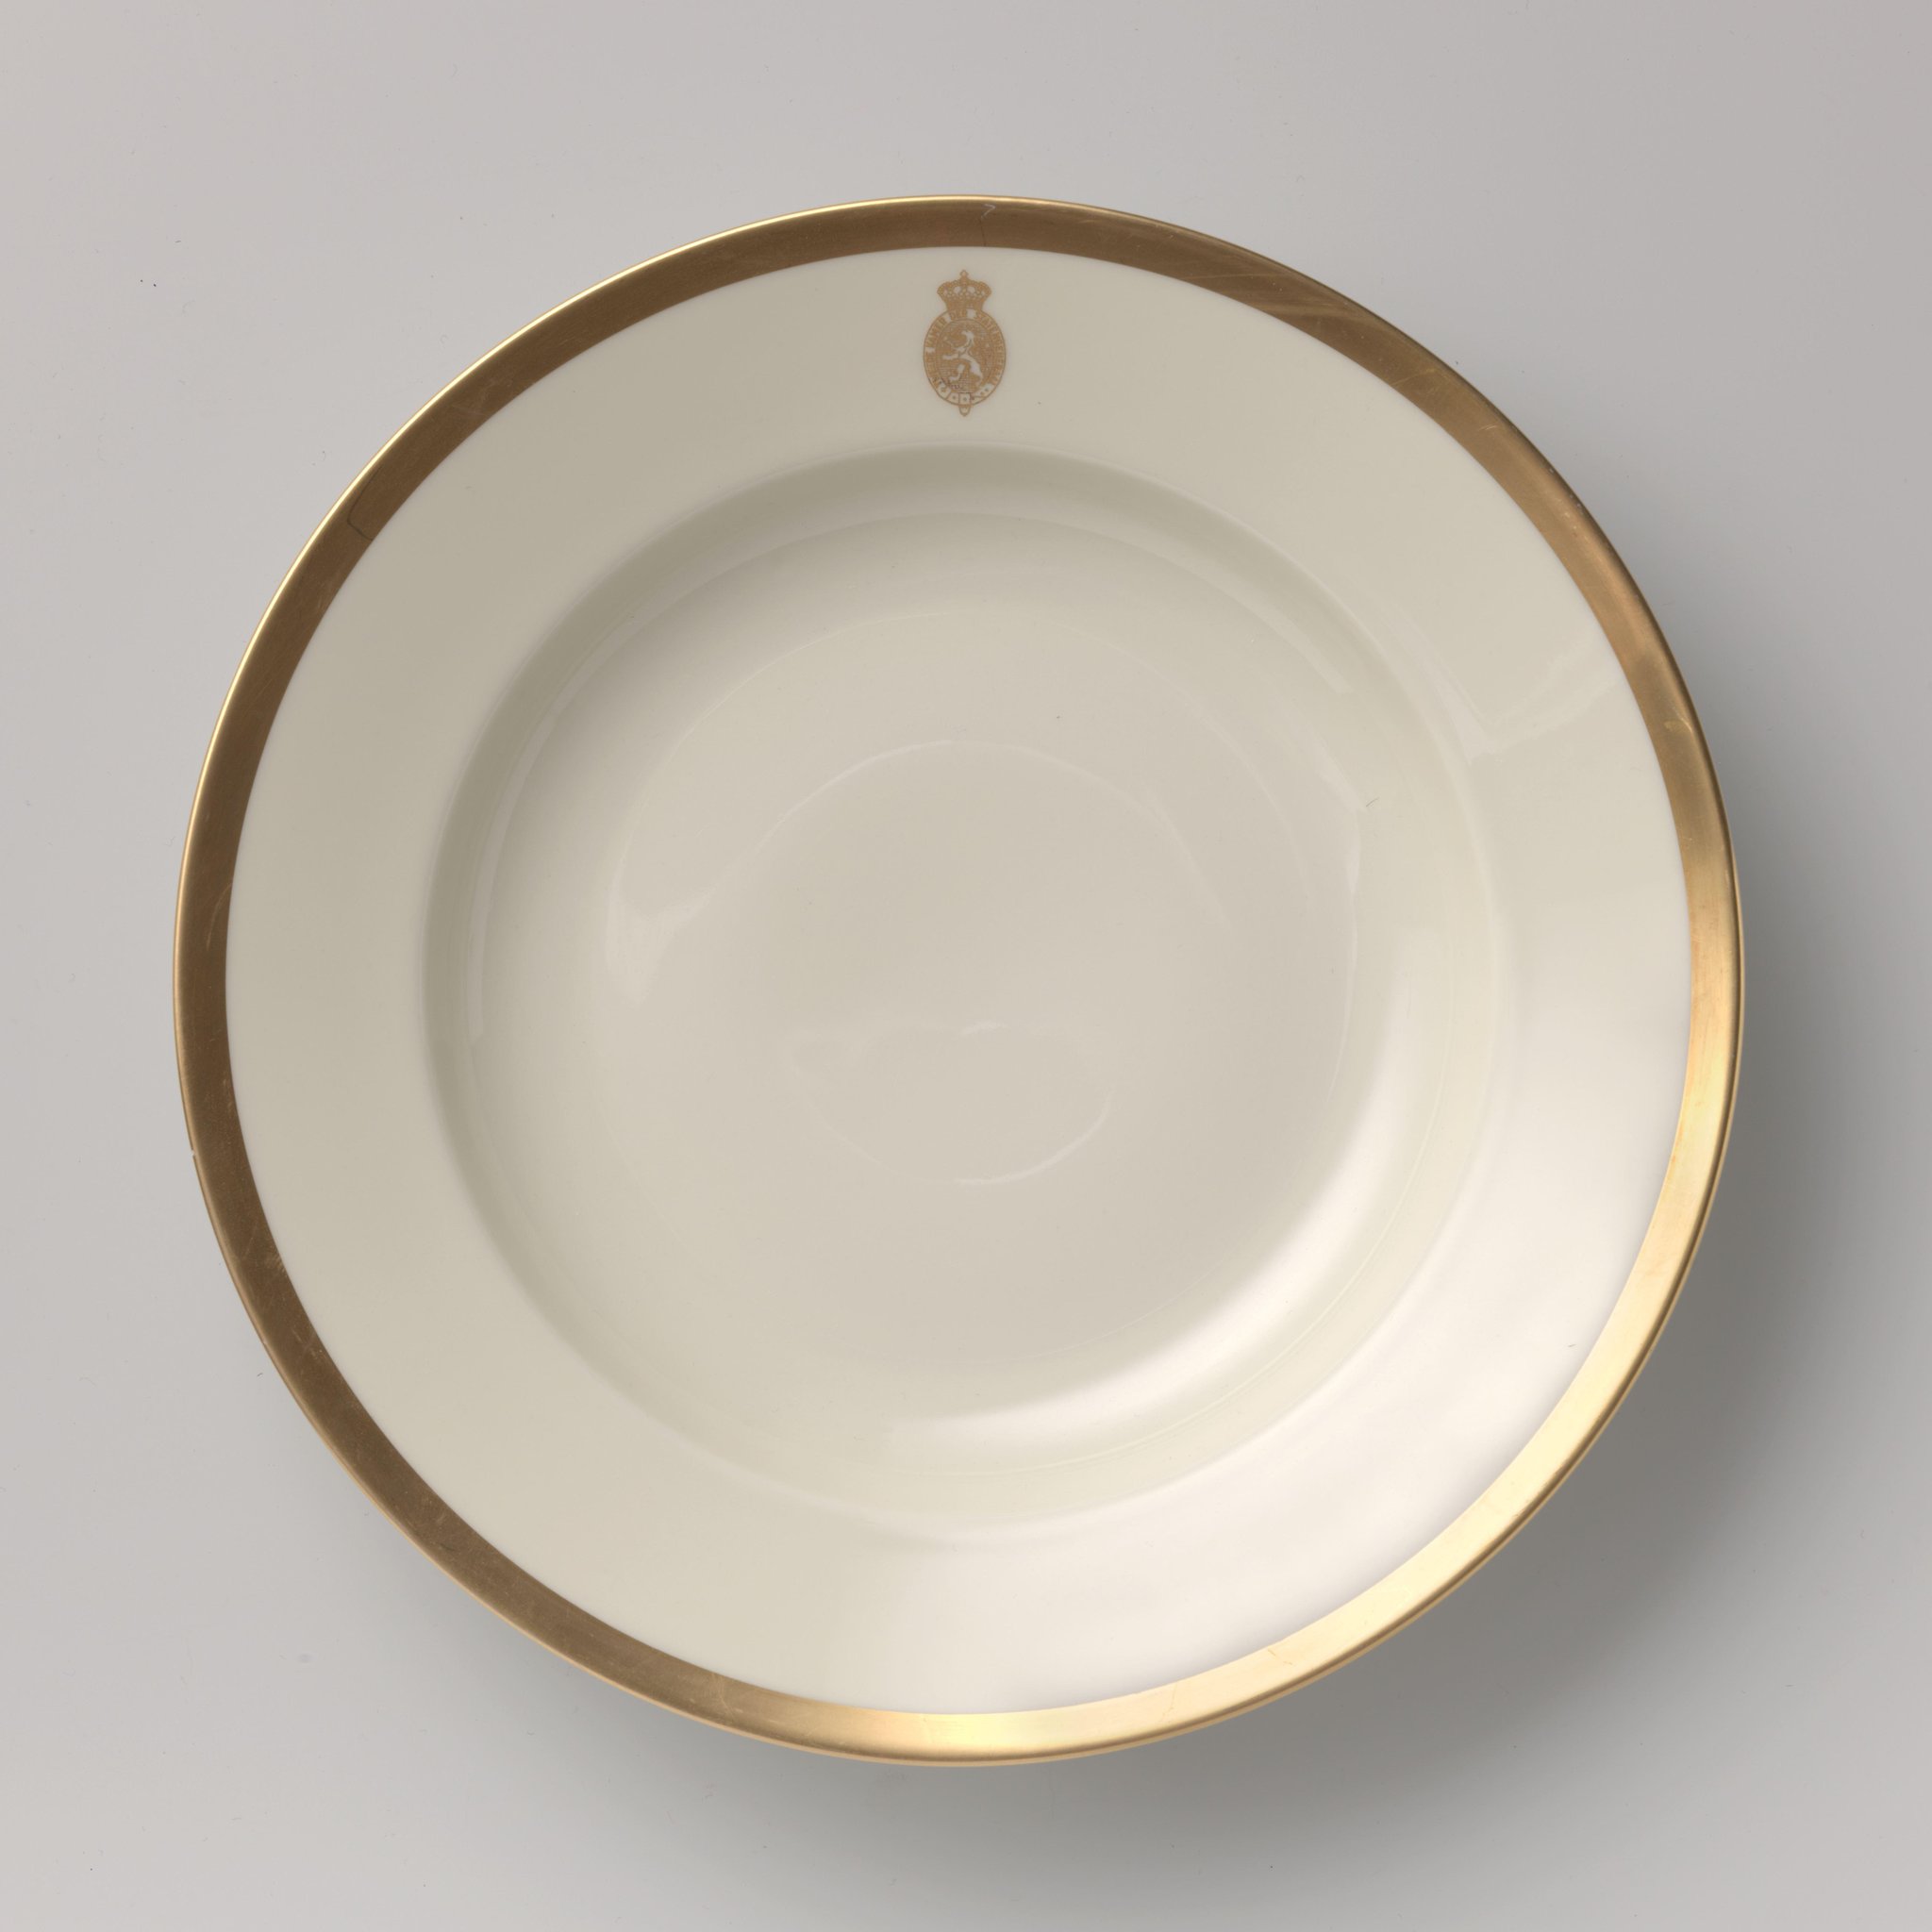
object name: plate dish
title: Plate used in the House of Representatives of the Netherlands at official receptions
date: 1900-1974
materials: glaze, gold, paint, porcelain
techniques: firing, forming, vitrification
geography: the hague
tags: rotterdam, the hague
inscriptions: inscription: ‘TWEEDE KAMER DER STATENGENERAAL’, mark: ‘Hutschenreuther Selb/ leeuw met L.H.S. Bavaria Germany/ N/ P.A.W. Philippona Den Haag/ 25’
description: Diep bord van porselein, beschilderd op het glazuur in goud. Versierd met een gouden rand en het gekroonde wapen van de Tweede Kamer met het opschrift 'TWEEDE KAMER DER STATENGENERAAL'. Gemerkt op de onderzijde met het fabrieksmerk, 'P.A.W. PHILIPPONA DEN HAAG', N en 25. Mogelijk gedecoreerd in Den Haag.